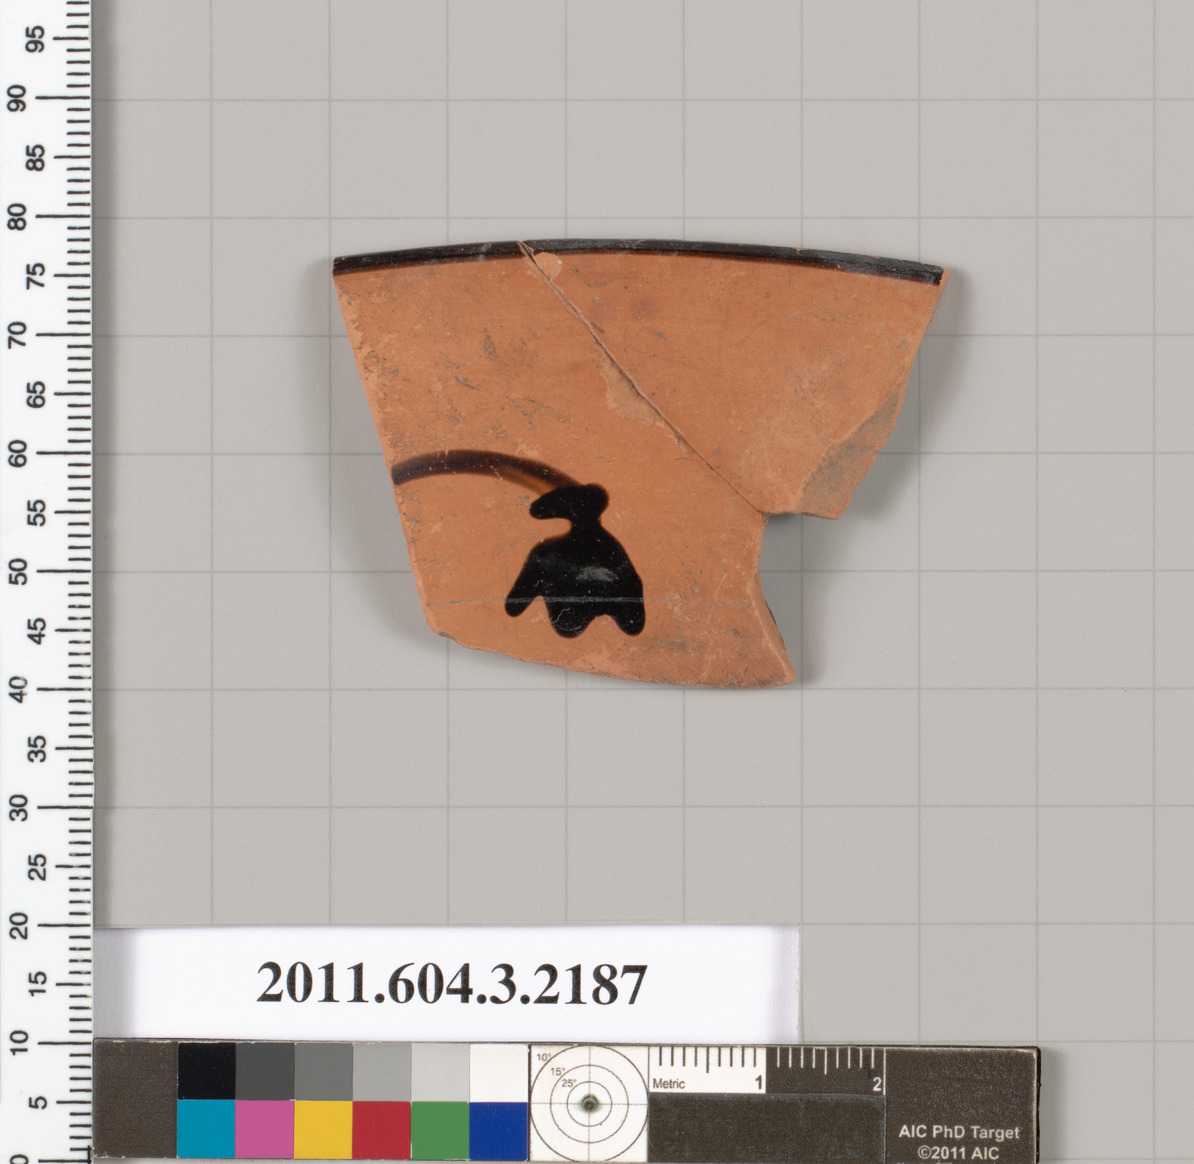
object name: kylix fragment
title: Terracotta rim fragment of a kylix (drinking cup)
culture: greek, attic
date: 500-468 BCE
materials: terracotta